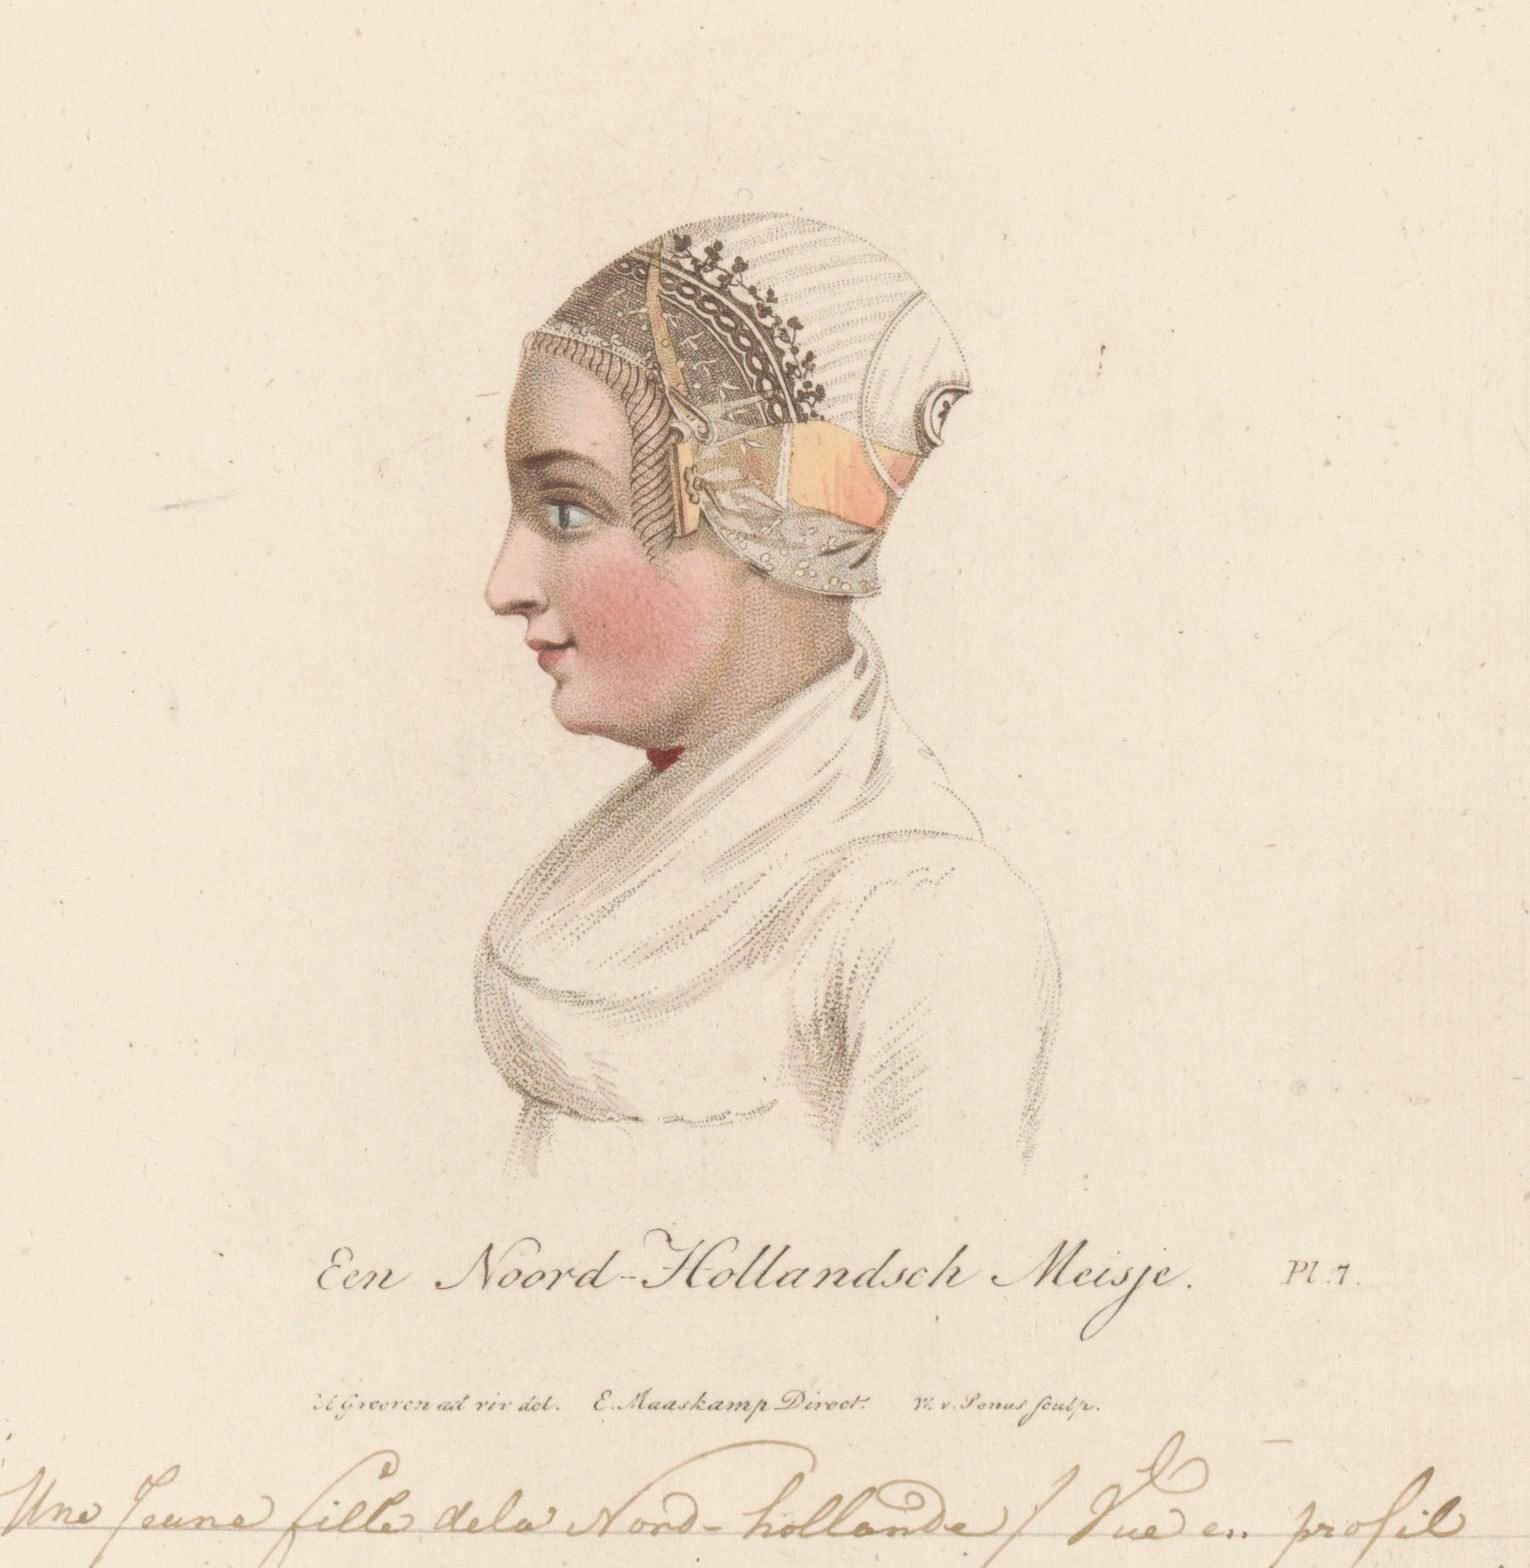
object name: print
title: Hoofddracht van een meisje uit Noord-Holland, 1816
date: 1816-1817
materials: paper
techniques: etching, hand coloring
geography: amsterdam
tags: folk costume, regional costume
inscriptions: inscription: ‘Une Jeune fille de la Nord-hollande / Vue en profil’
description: Buste van een jonge vrouw uit Noord-Holland in klederdracht, 1816. Gezien in profiel naar links, rechtsonder genummerd: Pl. 7. Onderdeel van een plaatwerk uit ca. 1824-1825 met 74 (ongenummerde) platen van de belangrijkste topografische gezichten en verschillende zeden en gewoonten in het Verenigd Koninkrijk der Nederlanden.